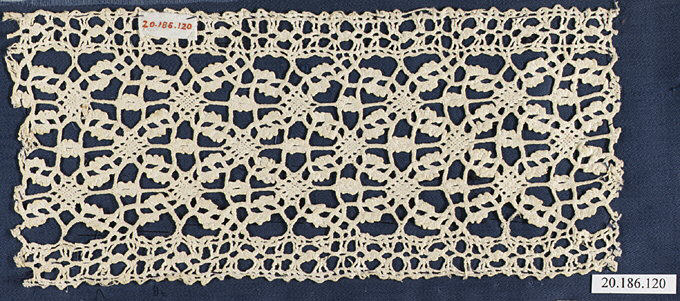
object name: insertion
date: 1601-1700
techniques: lace